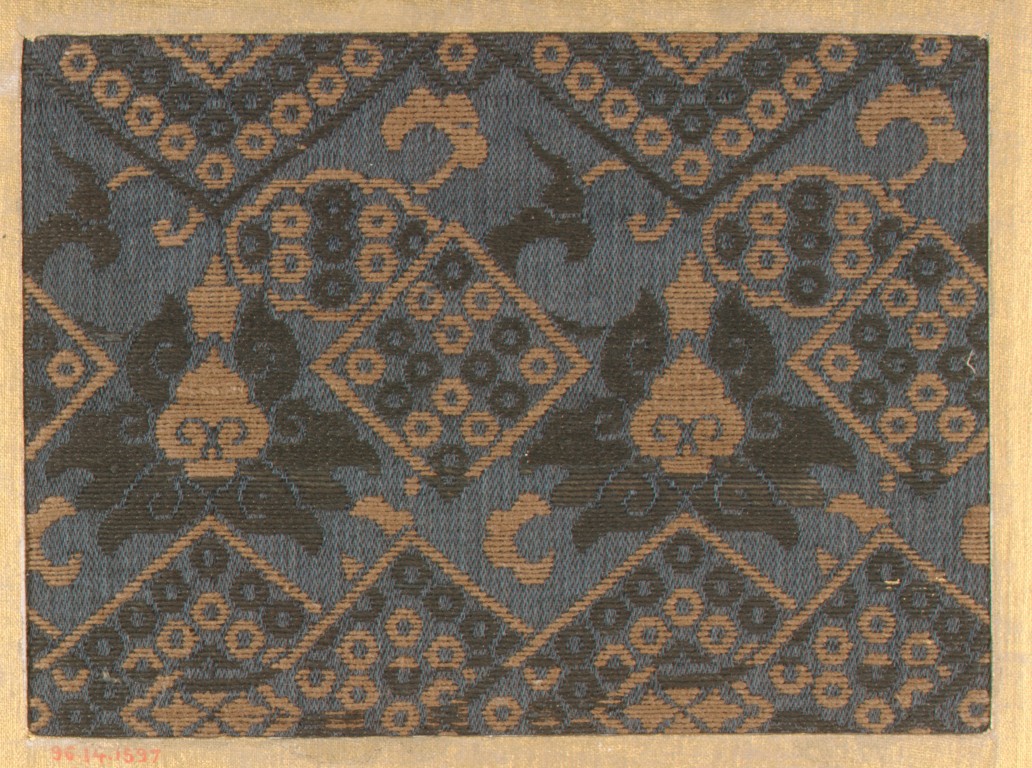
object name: piece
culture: japanese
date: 1701-1900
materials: silk